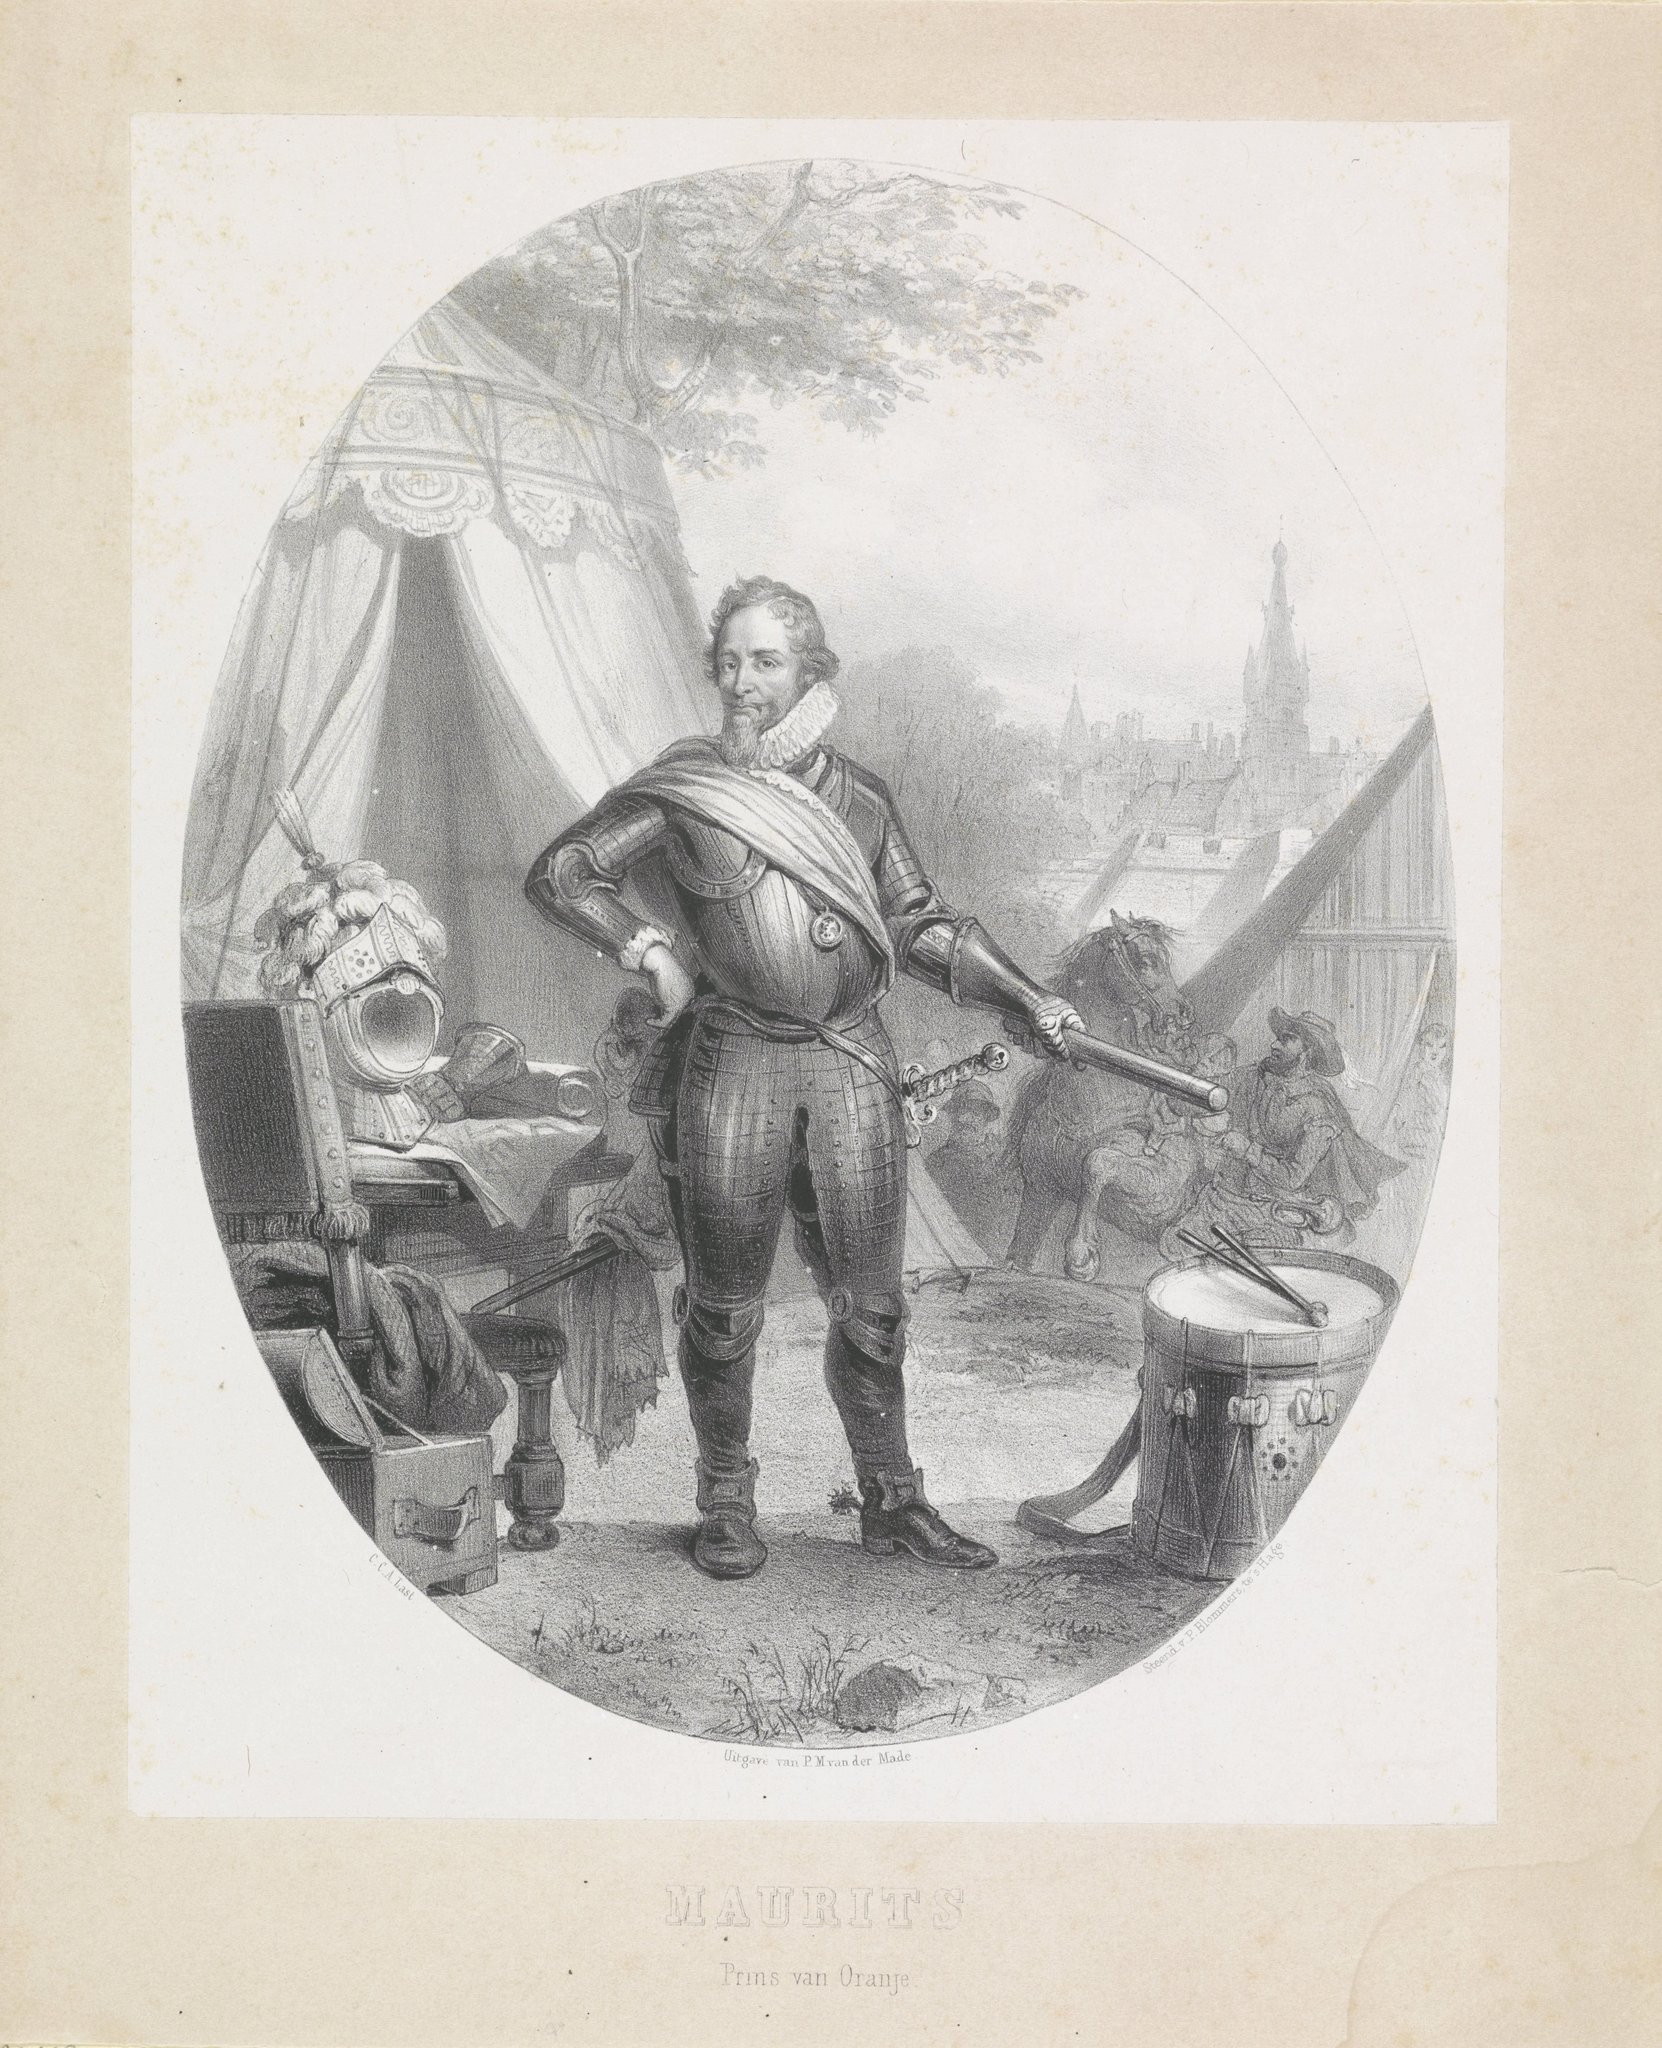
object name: print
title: Portret van Maurits, prins van Oranje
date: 1857-1873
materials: paper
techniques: lithograph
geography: netherlands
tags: the hague, maurice (prince of orange)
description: De hier vermelde titel verwijst naar de hoogst verkregen titel van de geportretteerde, niet per se naar de titel die de geportretteerde op deze voorstelling draagt.